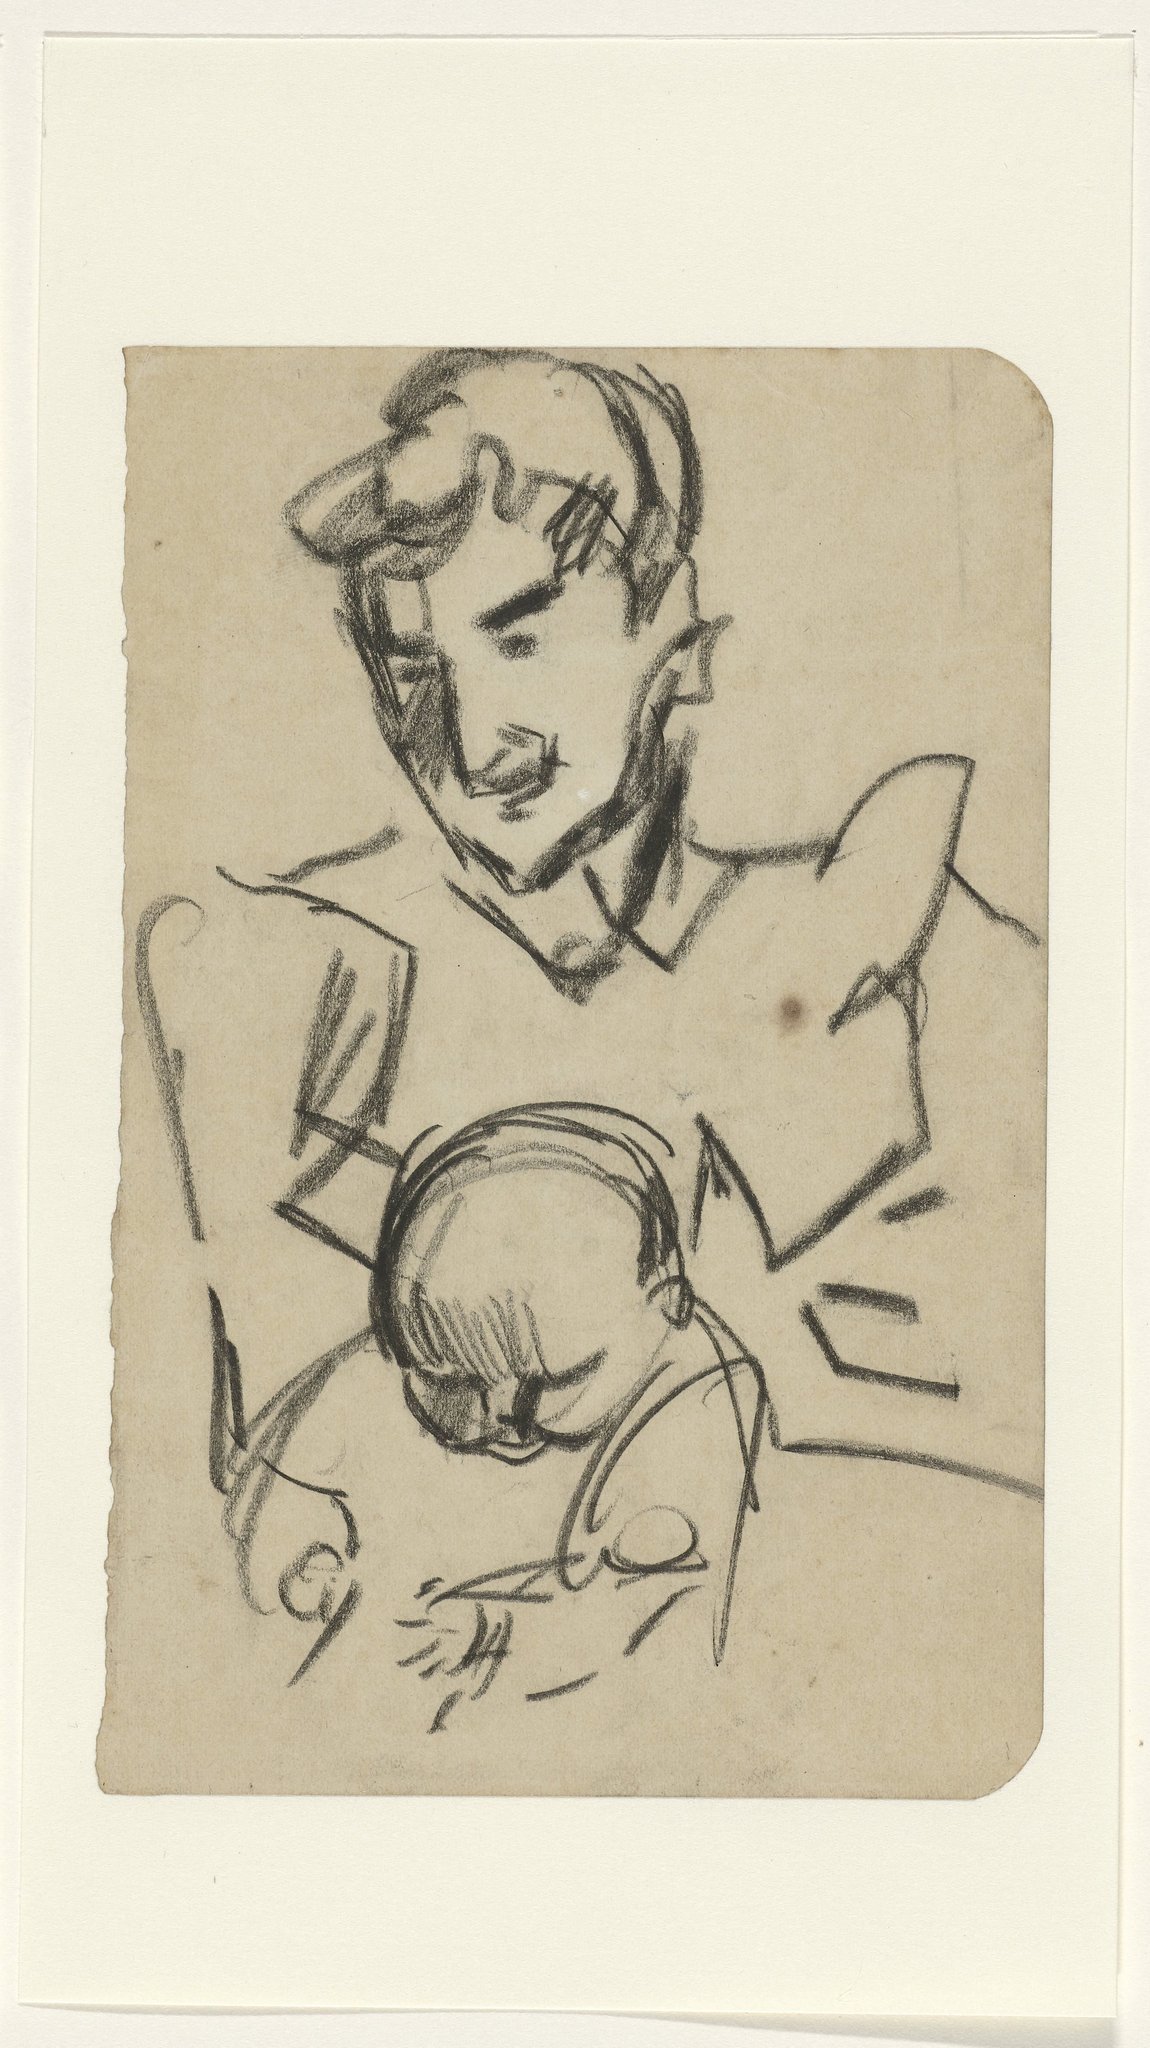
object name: drawing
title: Moeder met kind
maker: isaac israels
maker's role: draughtsman, painter, print maker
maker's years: 1865-1934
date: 1875-1934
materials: chalk, paper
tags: mother and baby or young child